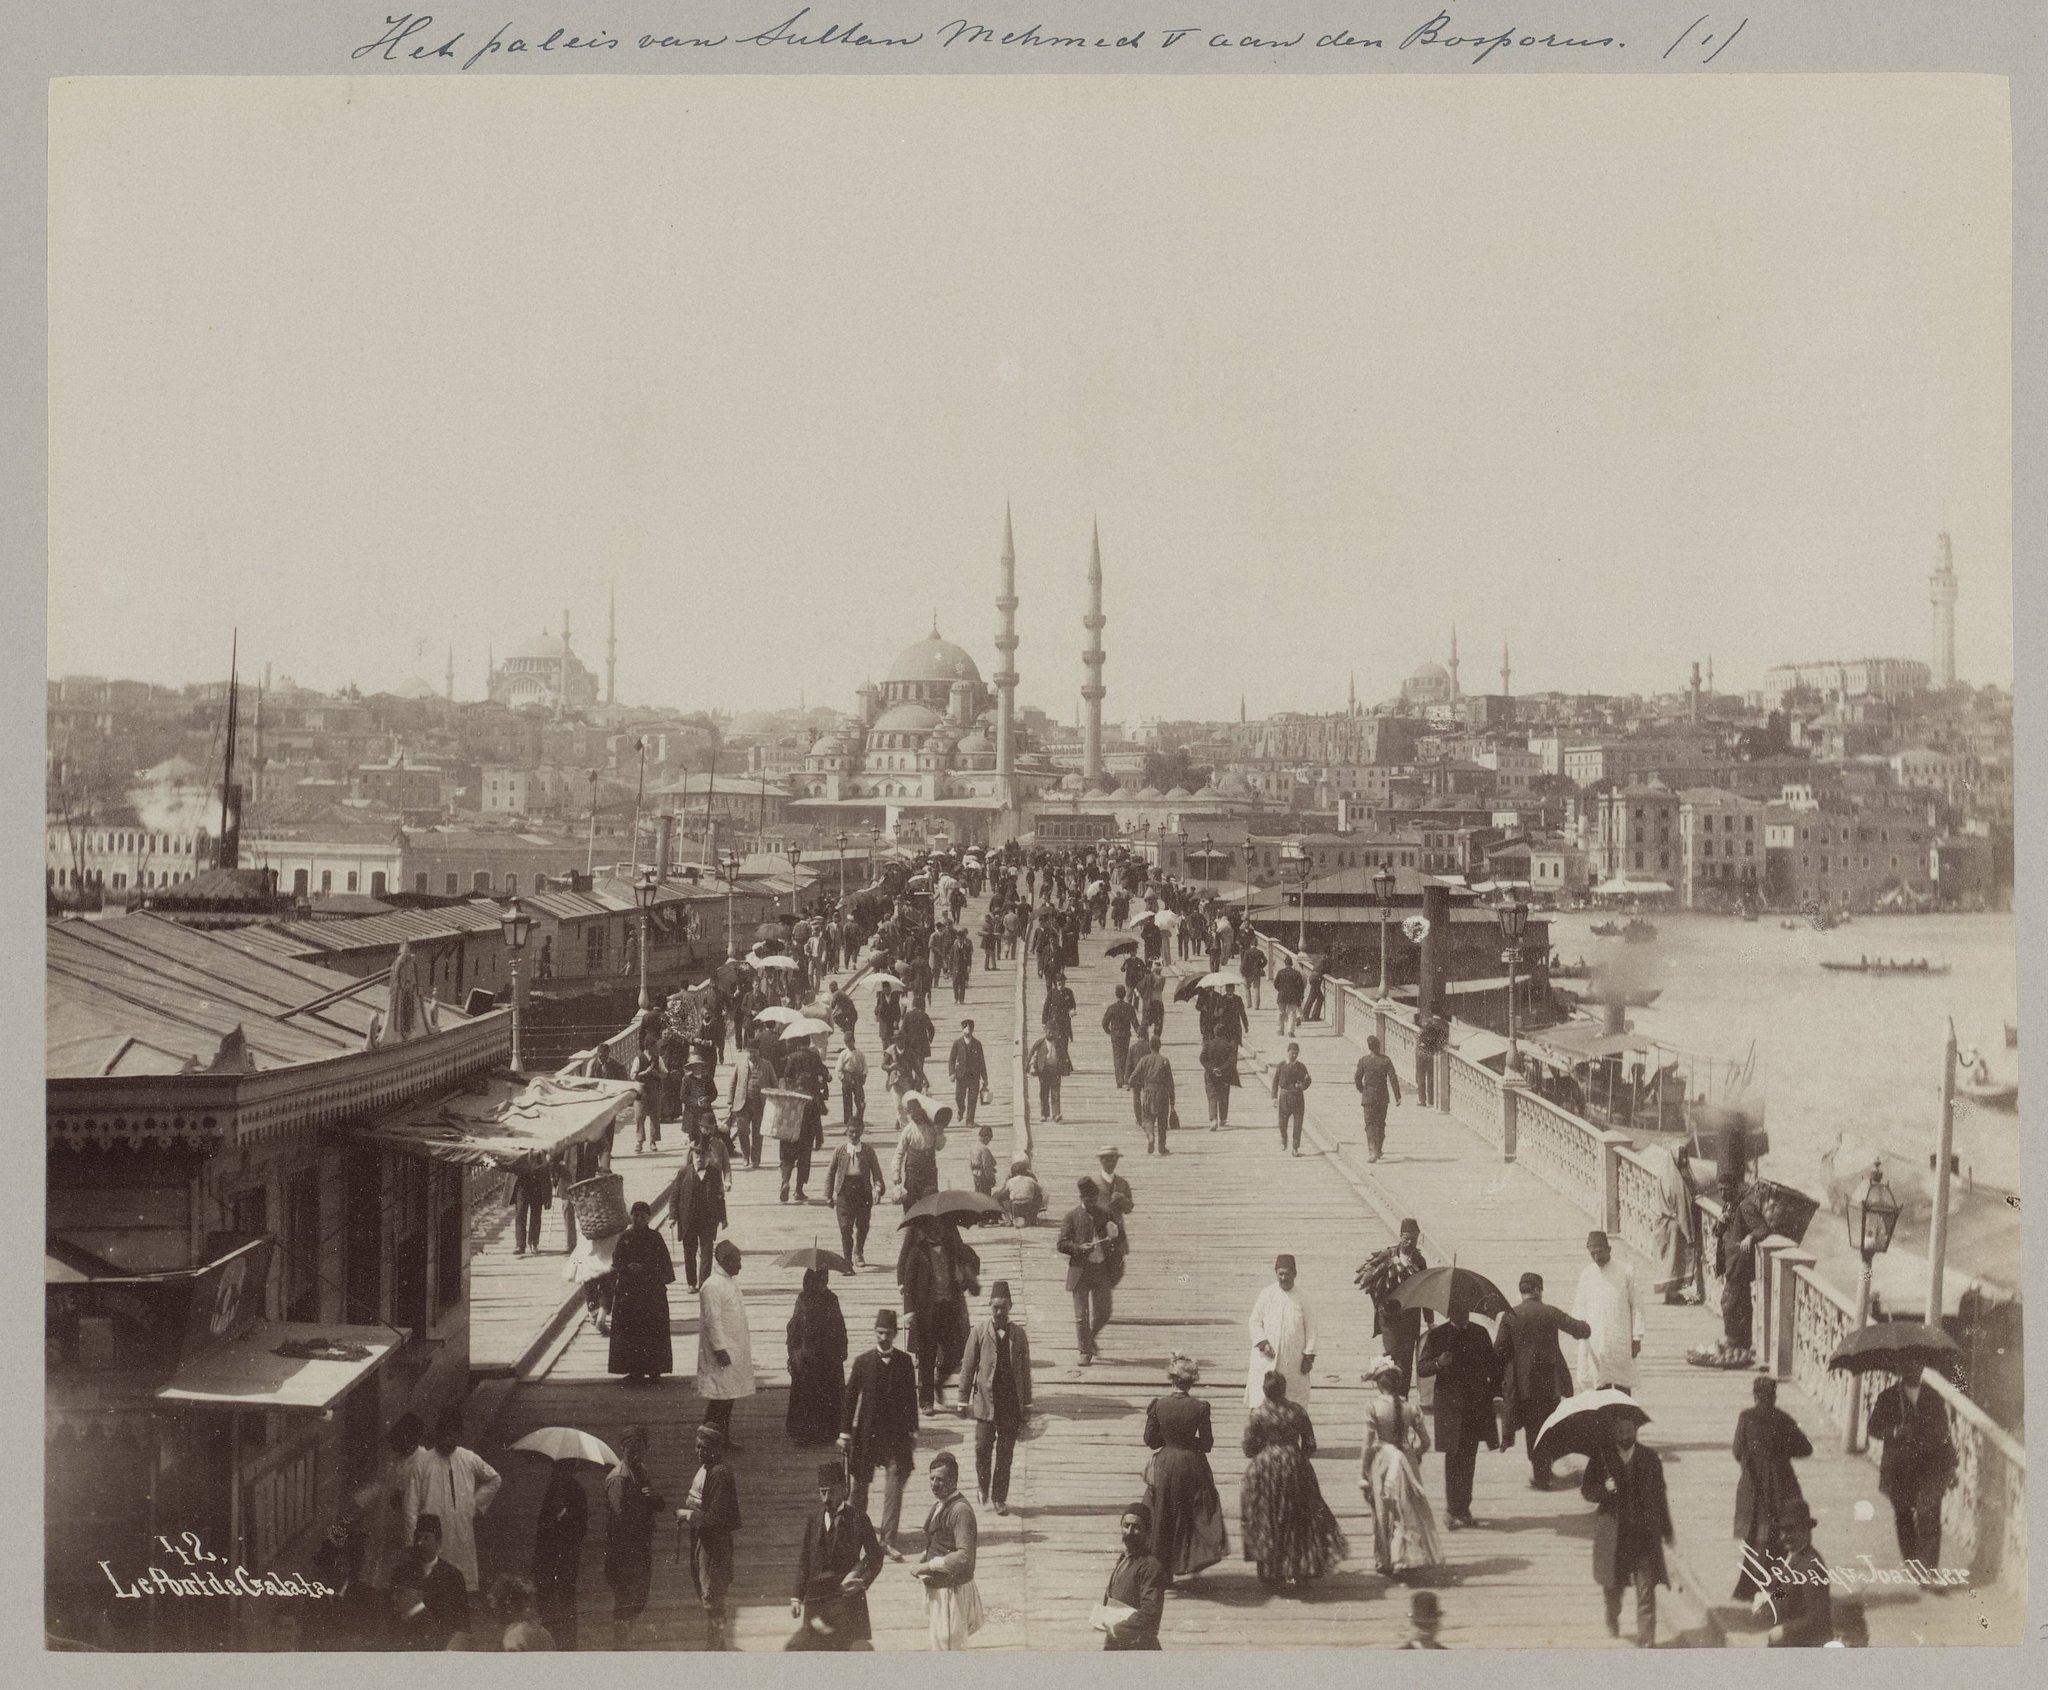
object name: photograph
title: Le Pont de Galata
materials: photographic support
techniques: albumen print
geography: istanbul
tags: bridge in city across river, canal, etc.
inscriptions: number: ‘42’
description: Het bijschrift boven deze foto behoort bij foto RP-F-F01141-CC. Dat boven foto RP-F-F01141-CC bij deze foto.